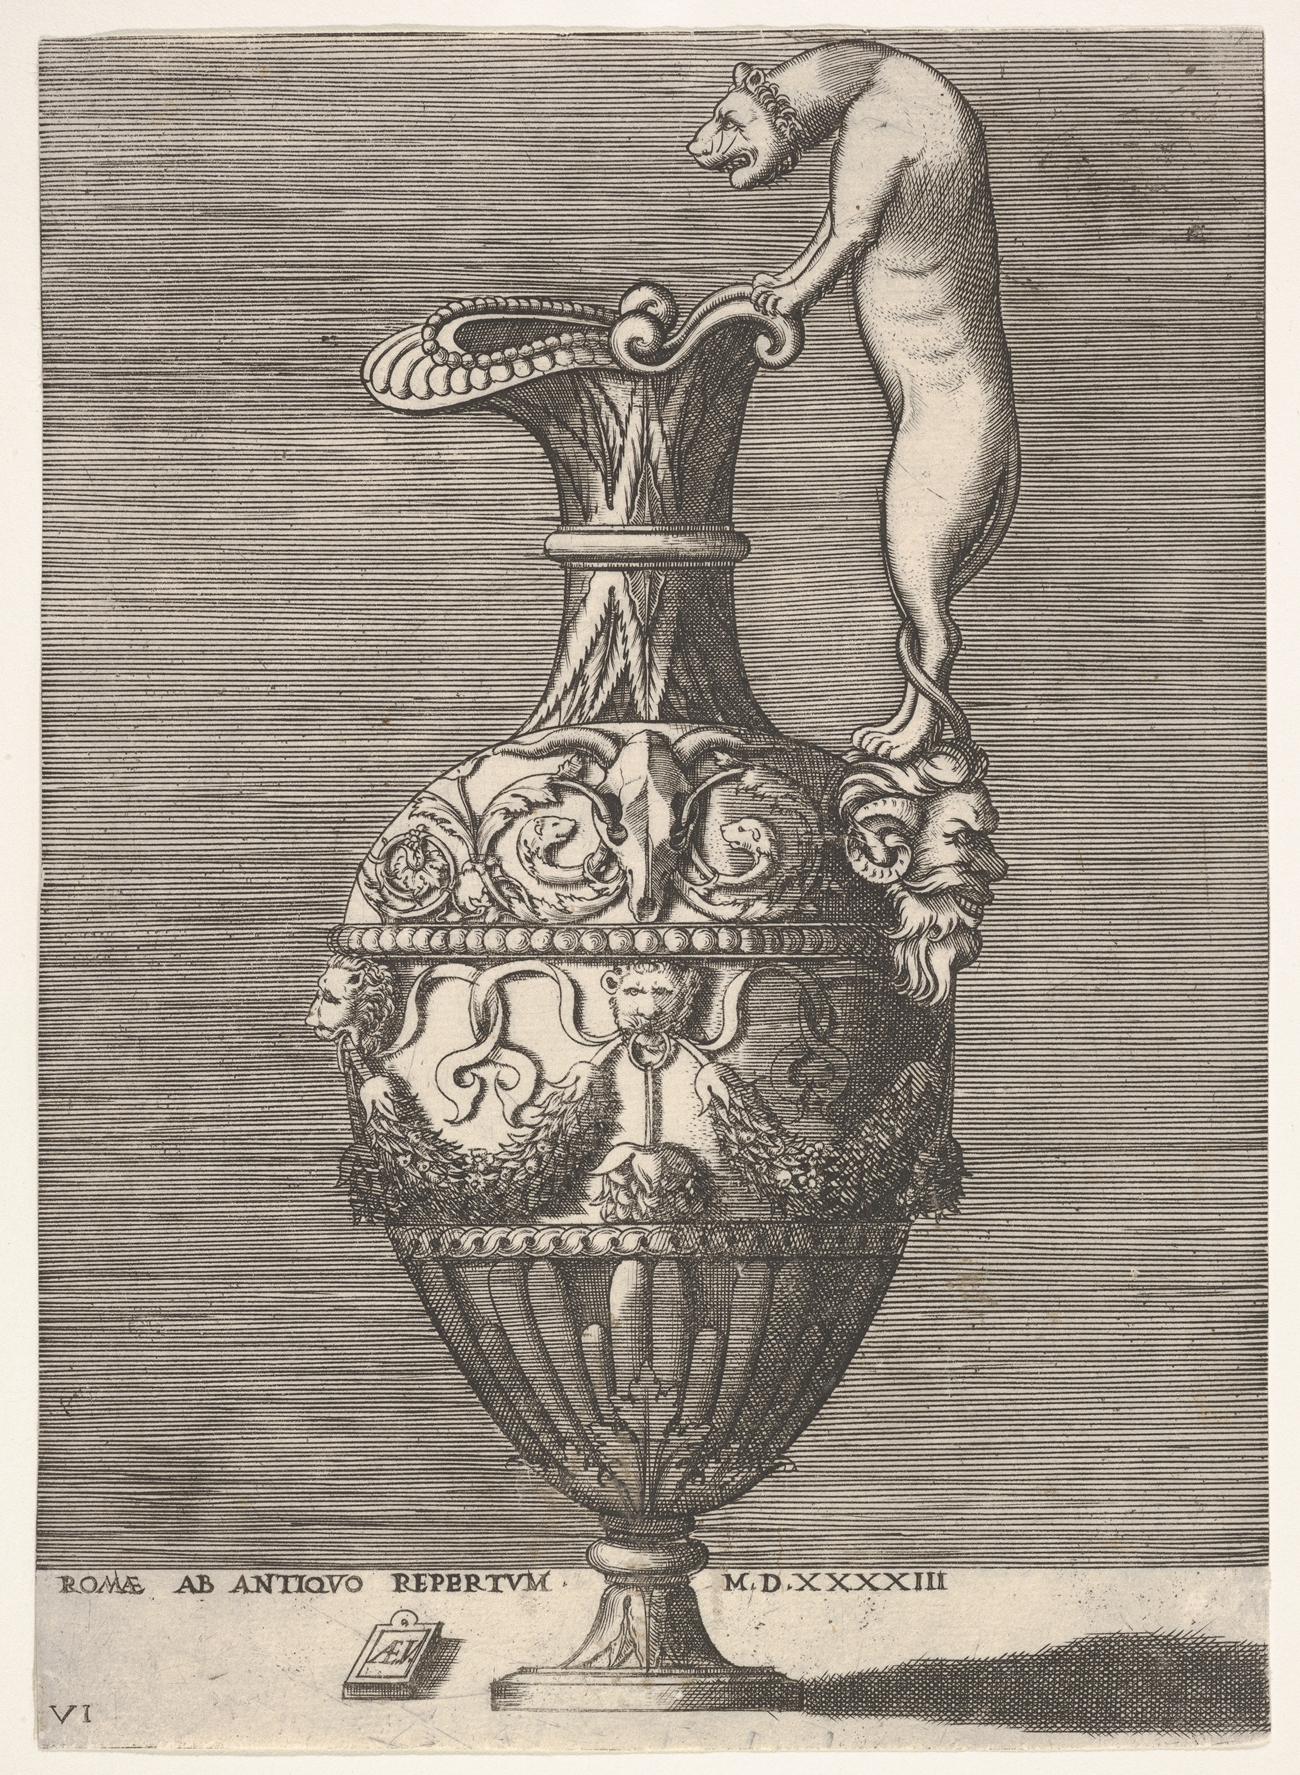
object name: print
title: Antique Ewer with a Handle in the Shape of a Lioness, from "Vases after the Antique"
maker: enea vico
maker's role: artist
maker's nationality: italian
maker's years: 1523-1567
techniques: engraving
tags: lions,ewers